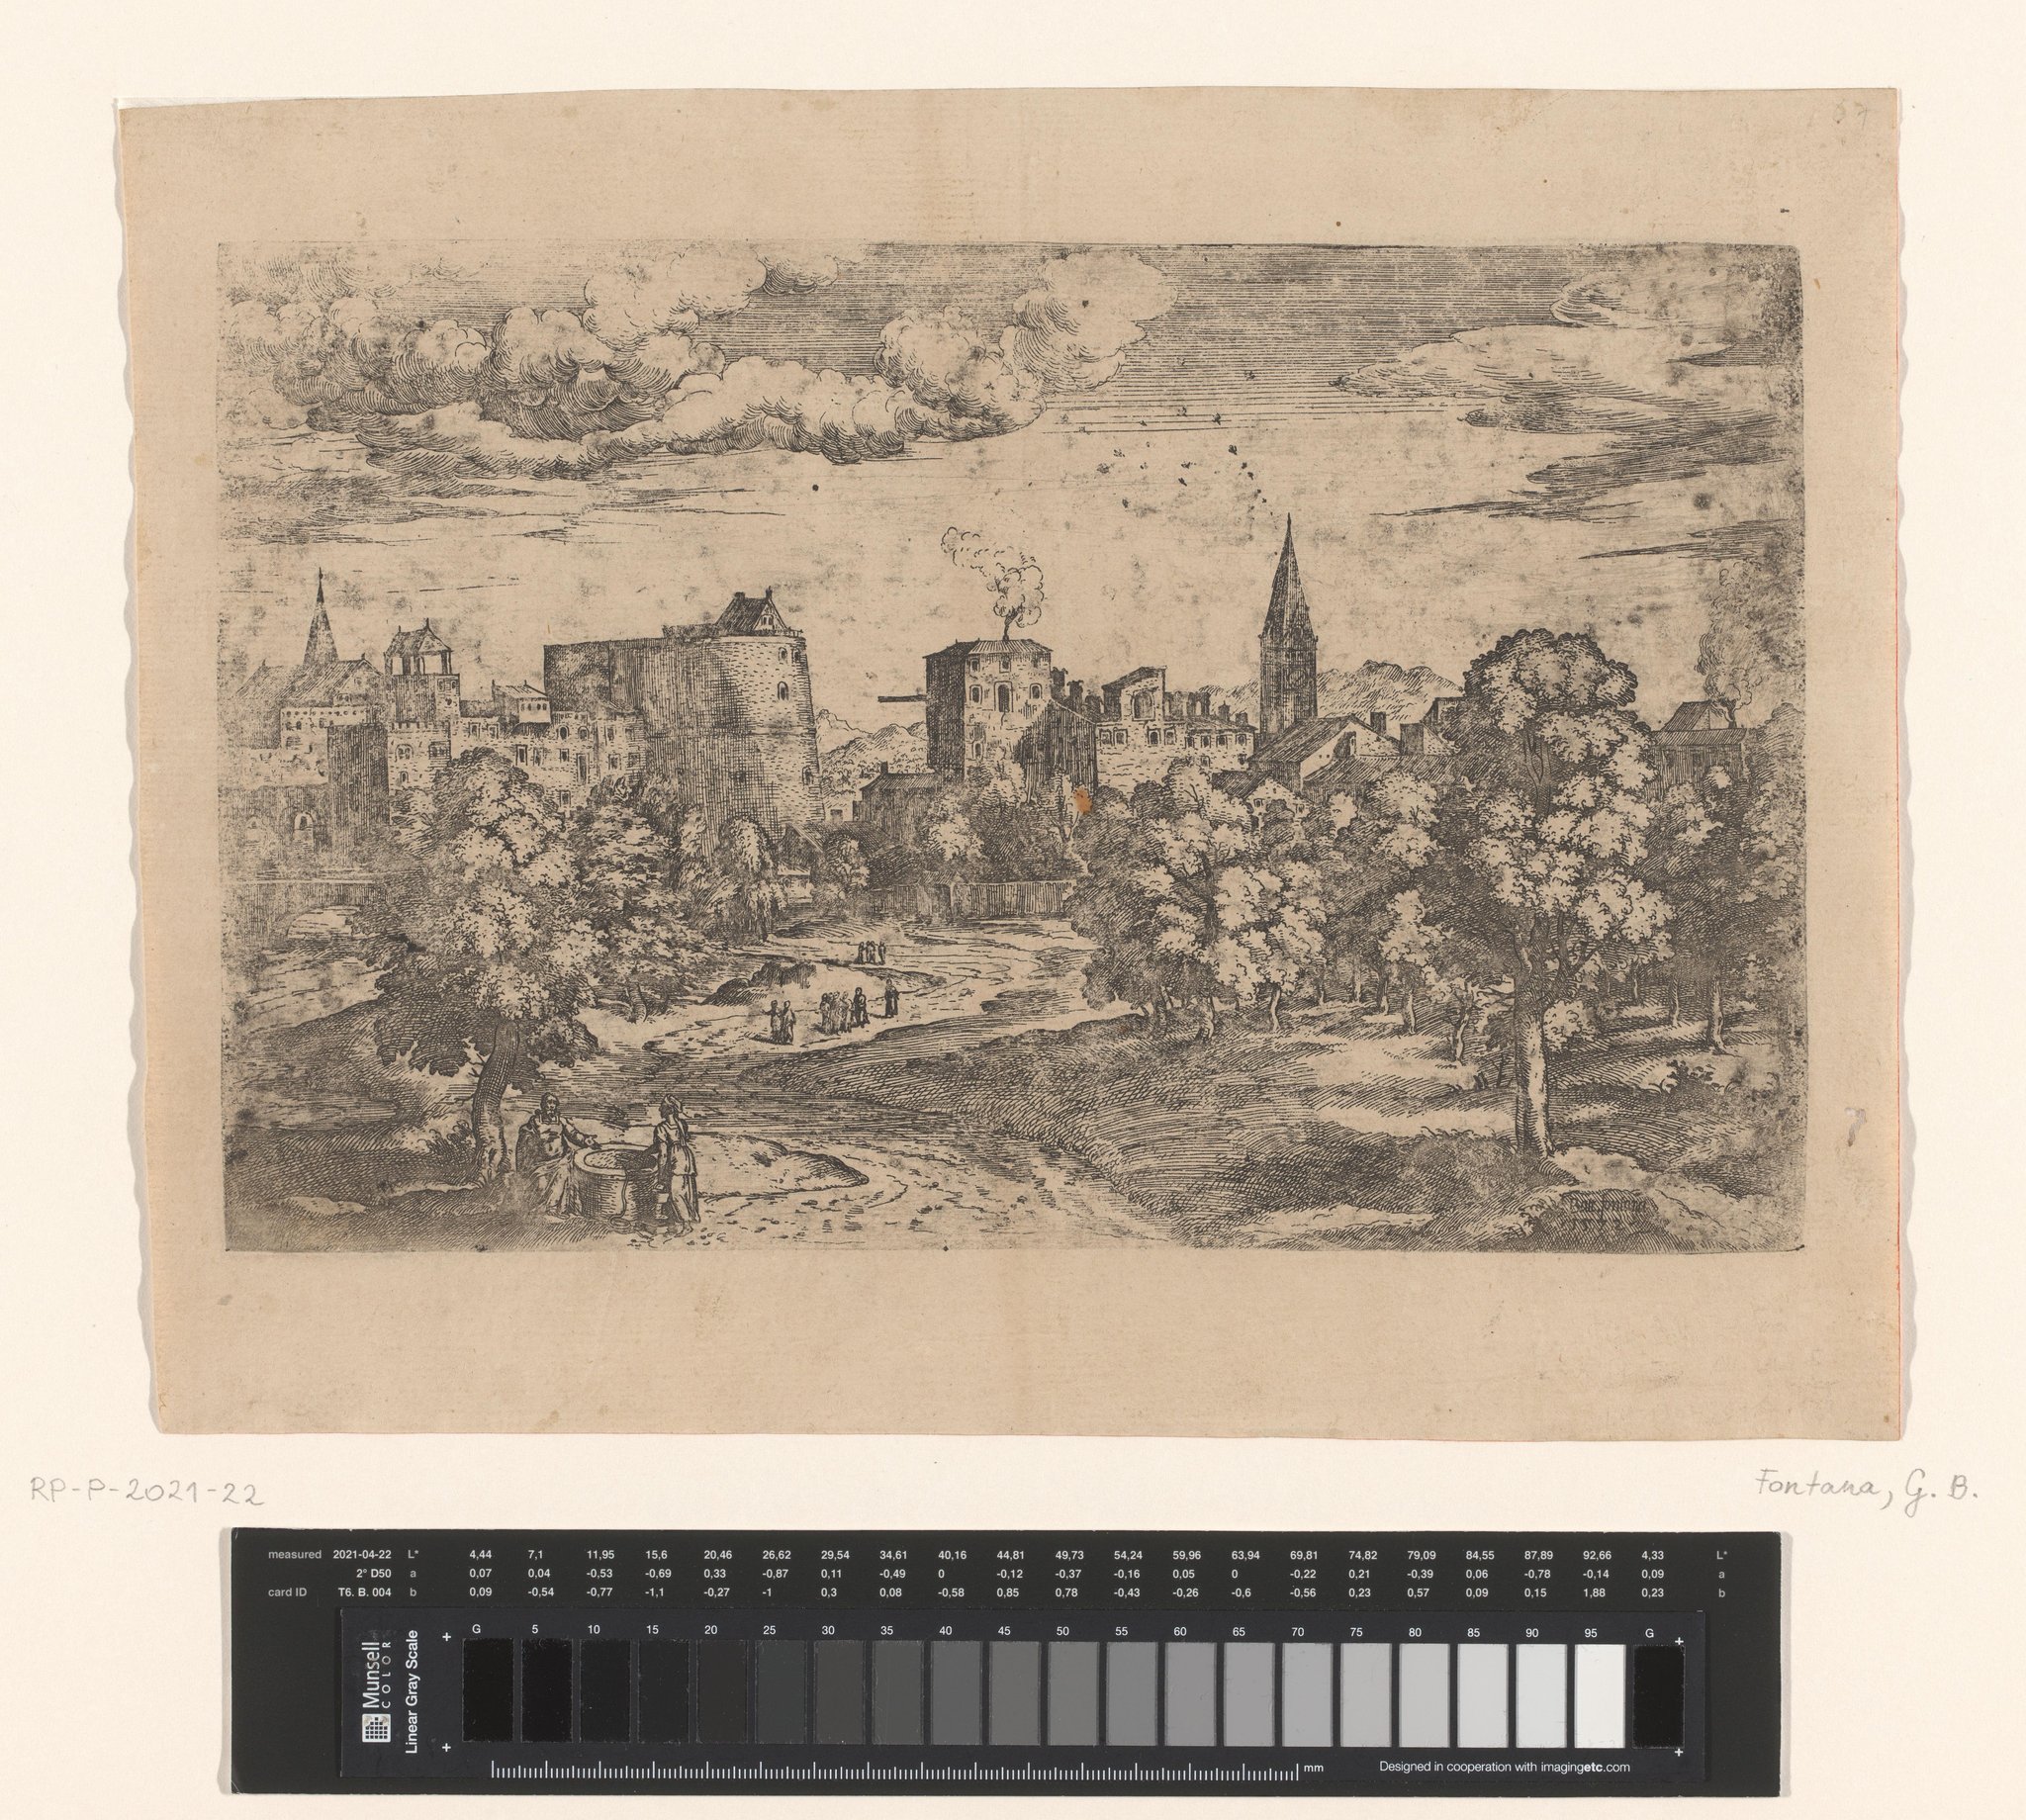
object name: print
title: Landschap met Christus en de Samaritaanse vrouw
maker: giovanni battista fontana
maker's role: draughtsman, painter, print maker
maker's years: 1524-1587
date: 1572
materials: paper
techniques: etching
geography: verona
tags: christ and the woman of samaria: sitting at jacob's well he asks her for a drink from her jug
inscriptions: watermark:, collector's mark: Lugt 2228, collector's mark: Lugt 2760, date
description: Boomrijk landschap met in het midden een weg waarop figuren lopen en in de achtergrond een zuidelijke stad met kerktorens en vestingwerken. Links op de voorgrond Christus en de Samaritaanse vrouw naast een waterput. Uit een serie van acht landschappen met scènes uit het leven van Christus en uit Zijn parabels, gedateerd 1572-73.